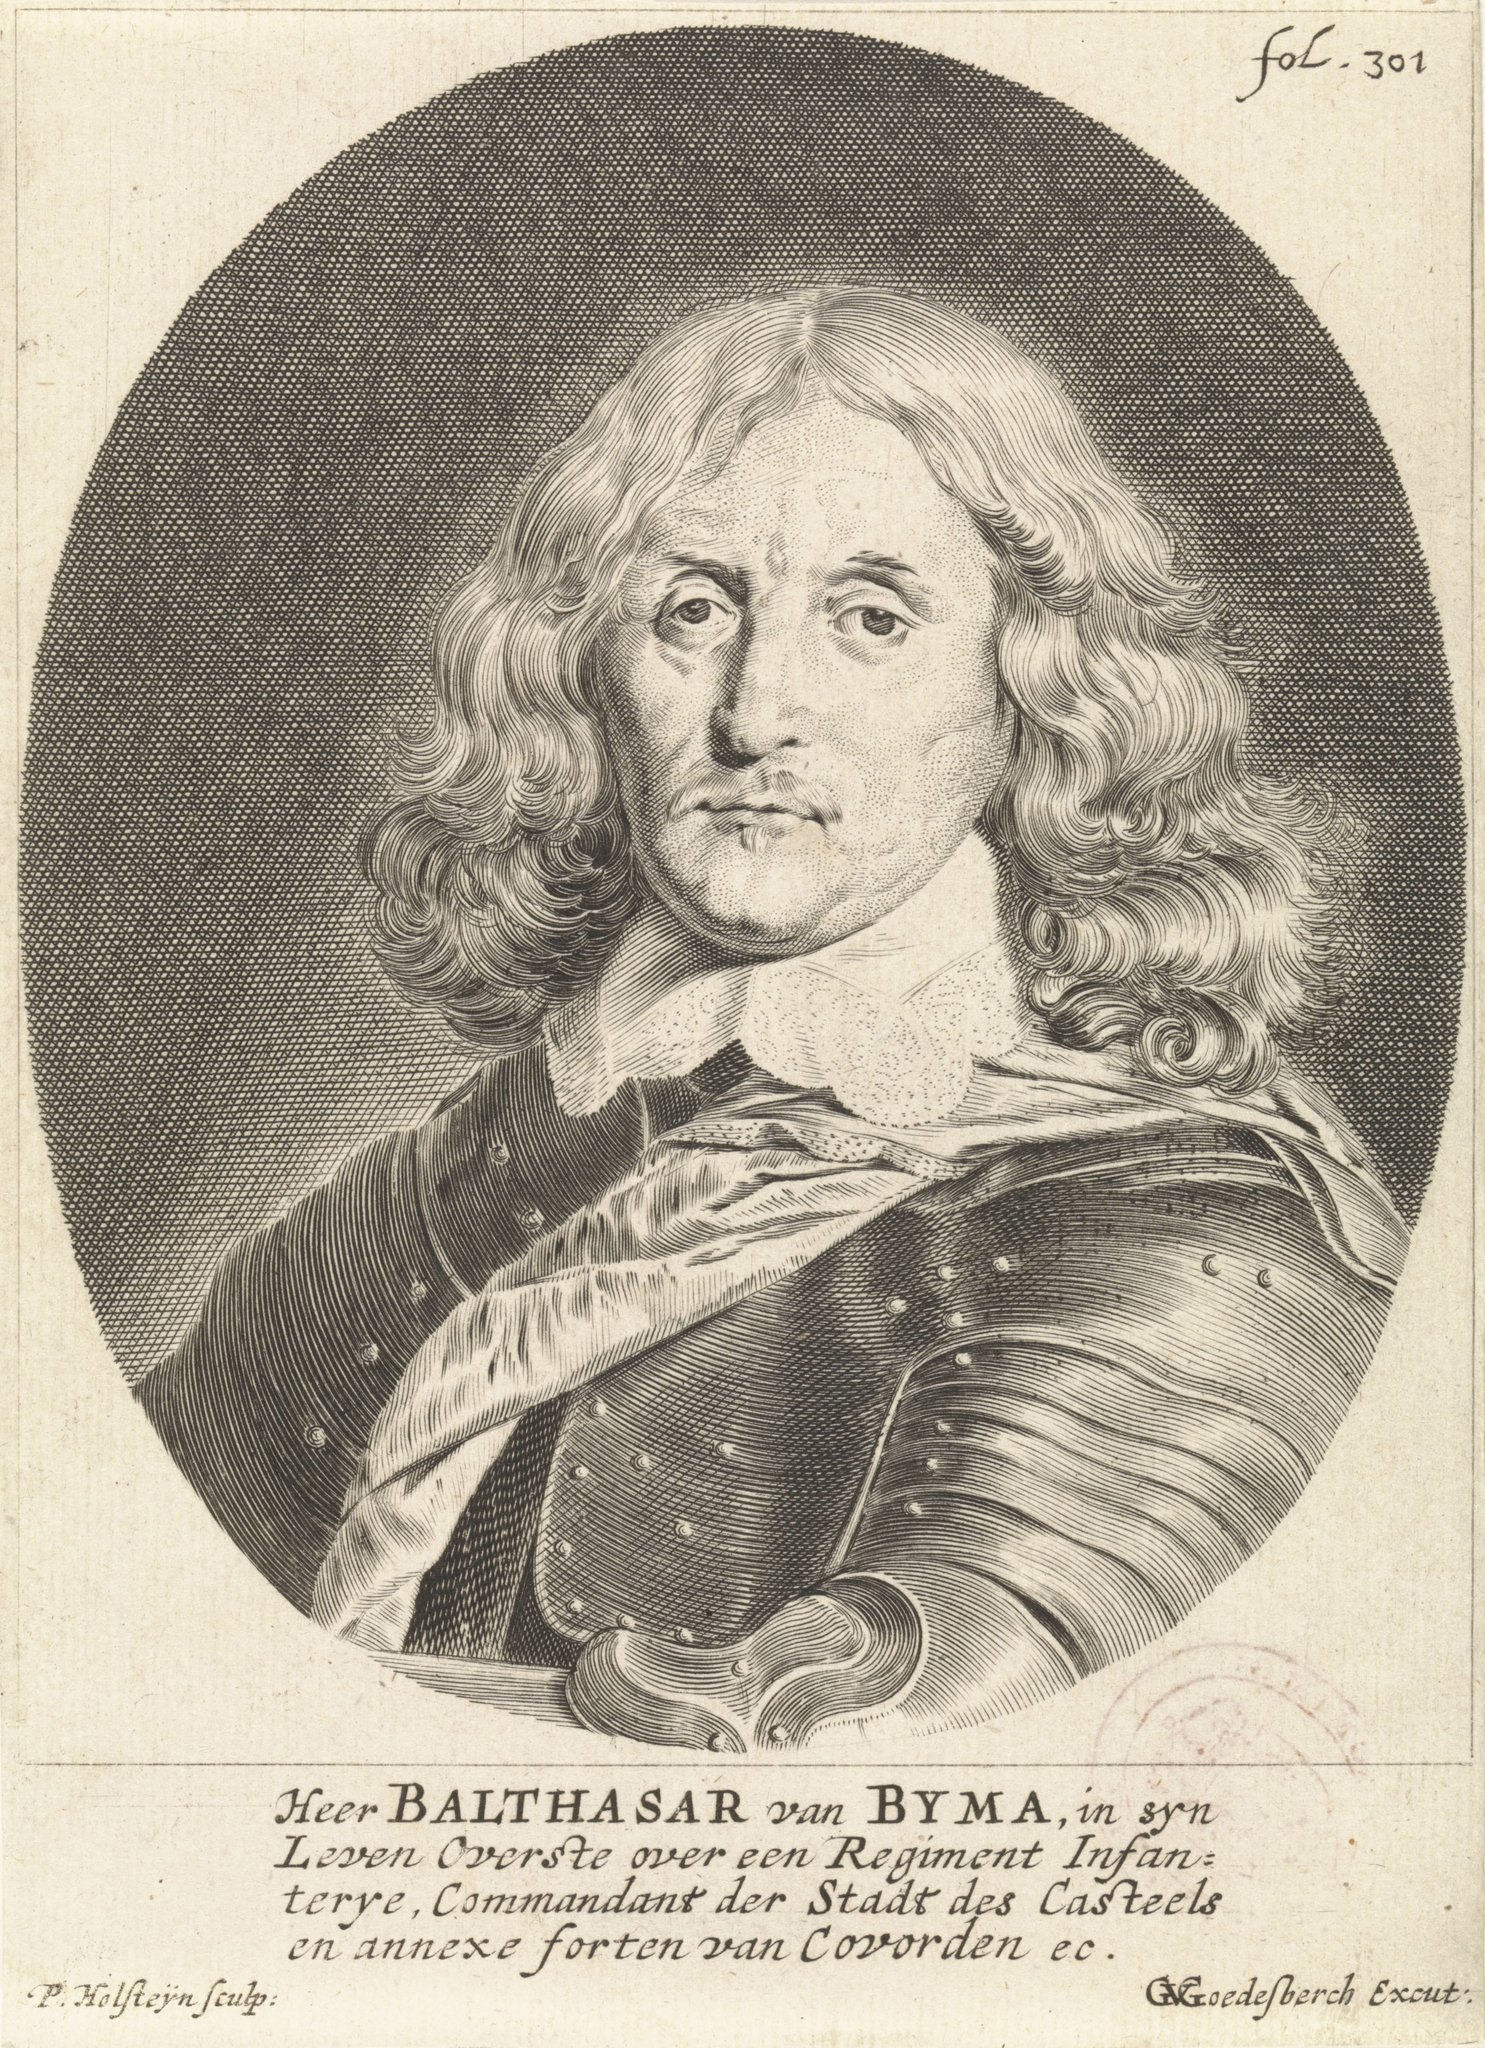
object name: print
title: Portret van Balthasar van Bijma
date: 1660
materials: paper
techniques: engraving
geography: amsterdam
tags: balthasar van bijma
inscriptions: collector's mark: Lugt 240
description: Prent gebruikt in: Johan Picardt, Korte beschryvinge van eenige vergetene en verborgene antiquiteten der provintien en landen gelegen tusschen de Noord-zee, de Yssel, Emse en Lippe. Amsterdam, 1660.